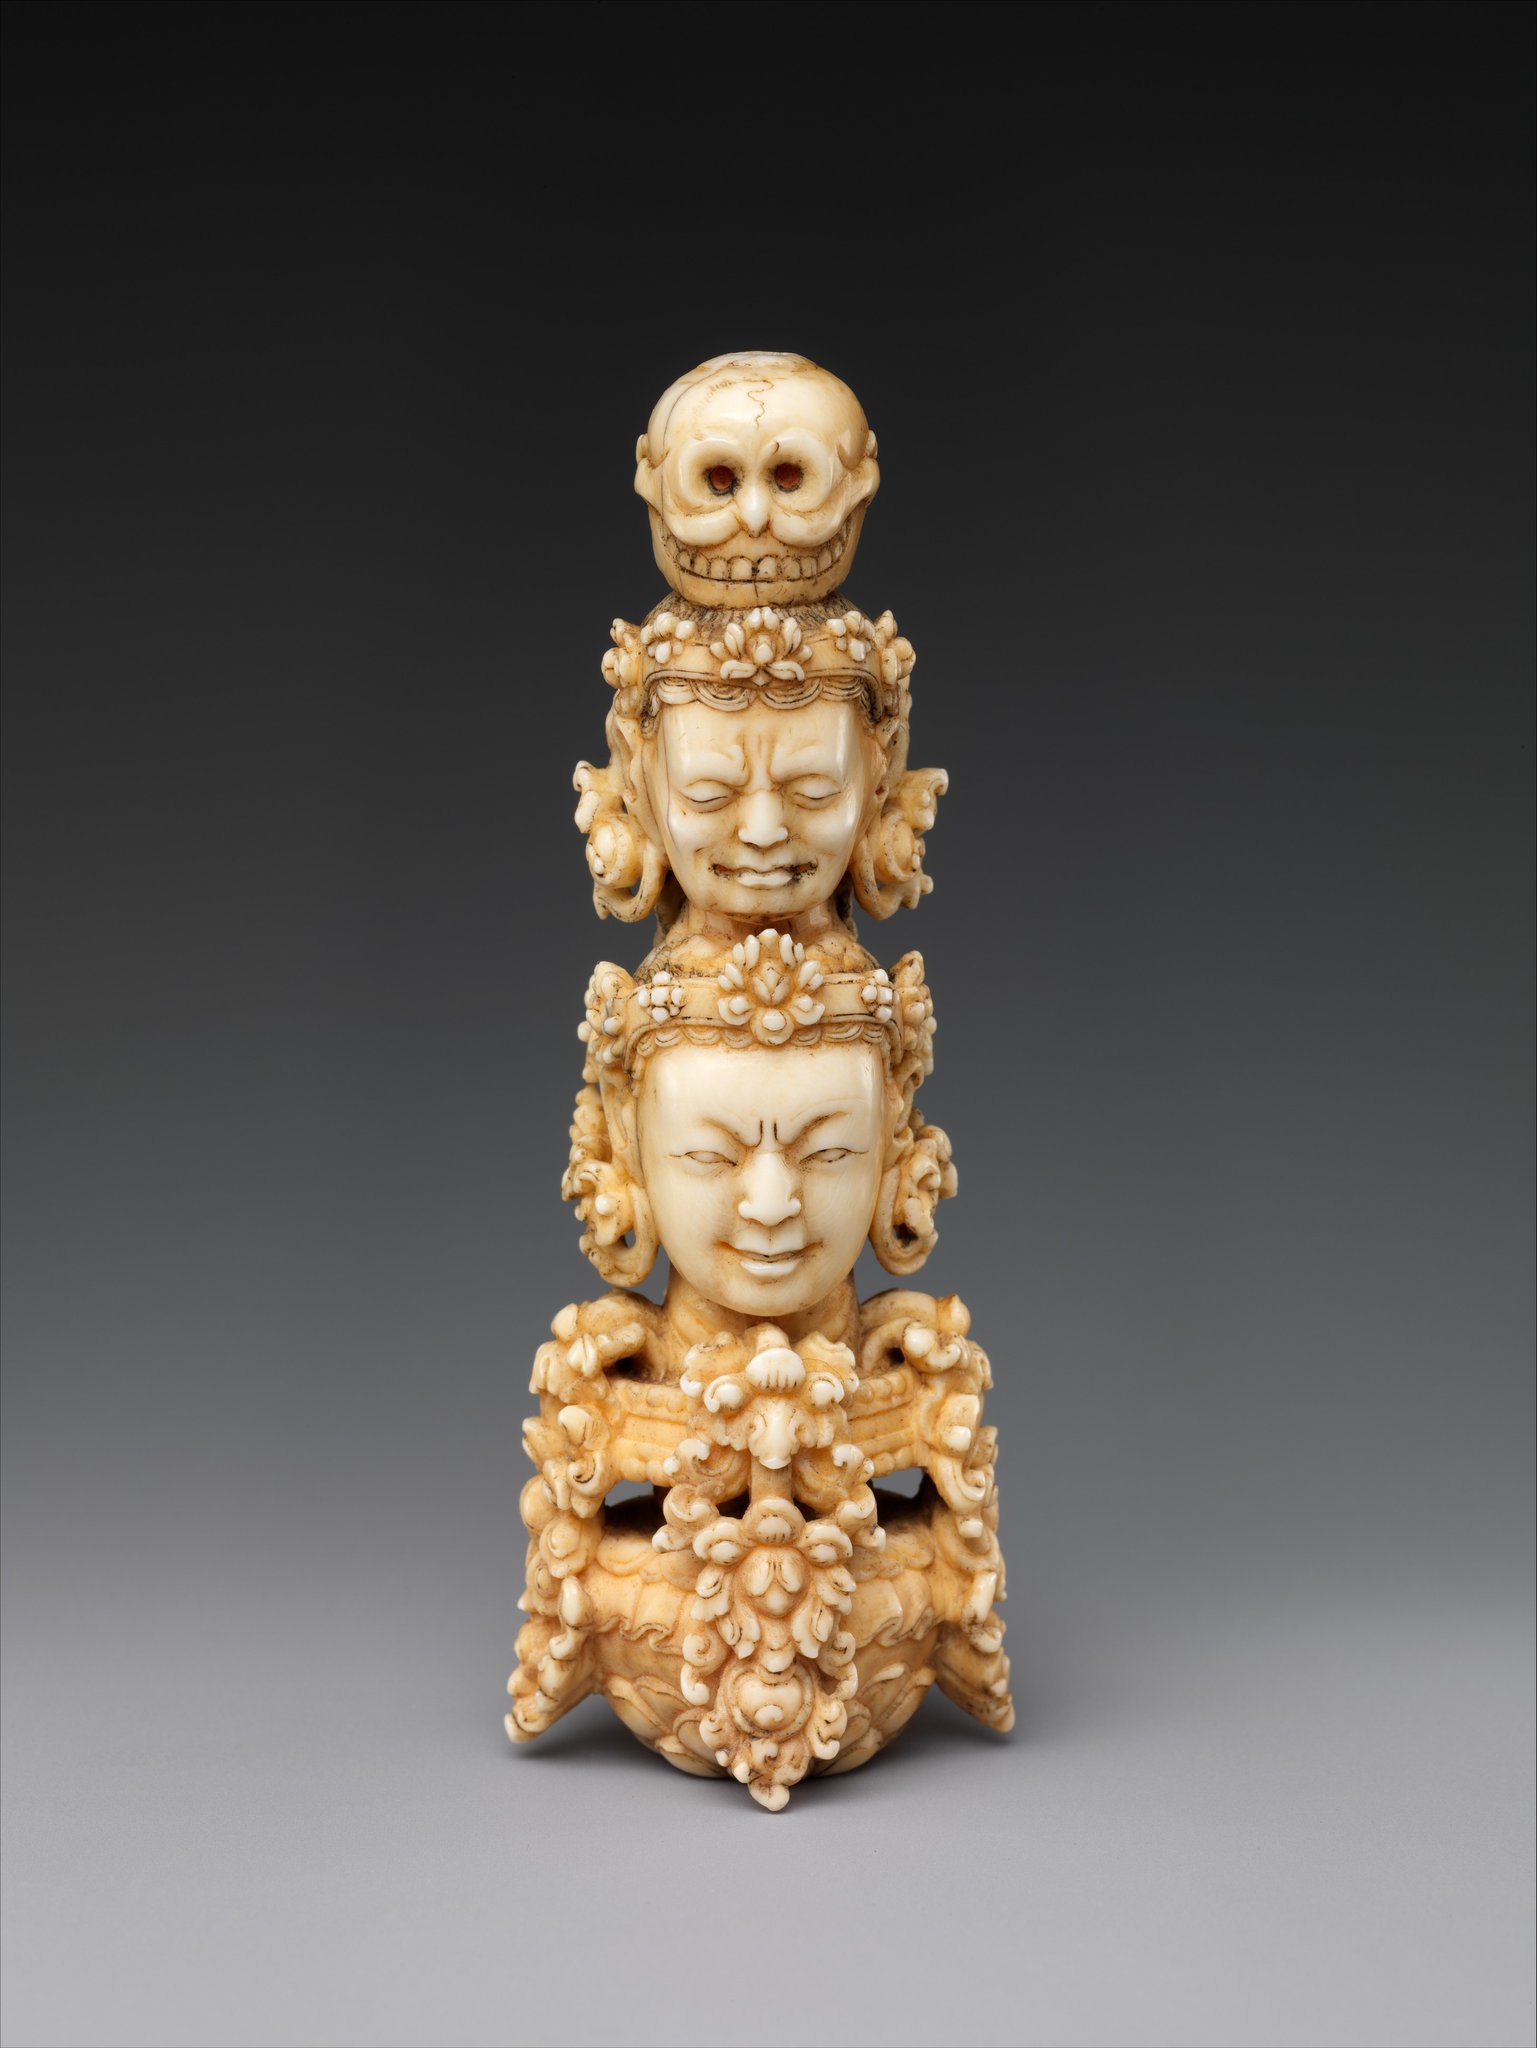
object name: finial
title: Finial for a Buddhist staff (khatvanga)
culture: chinese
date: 1401-1433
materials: ivory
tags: skulls,heads,buddhism